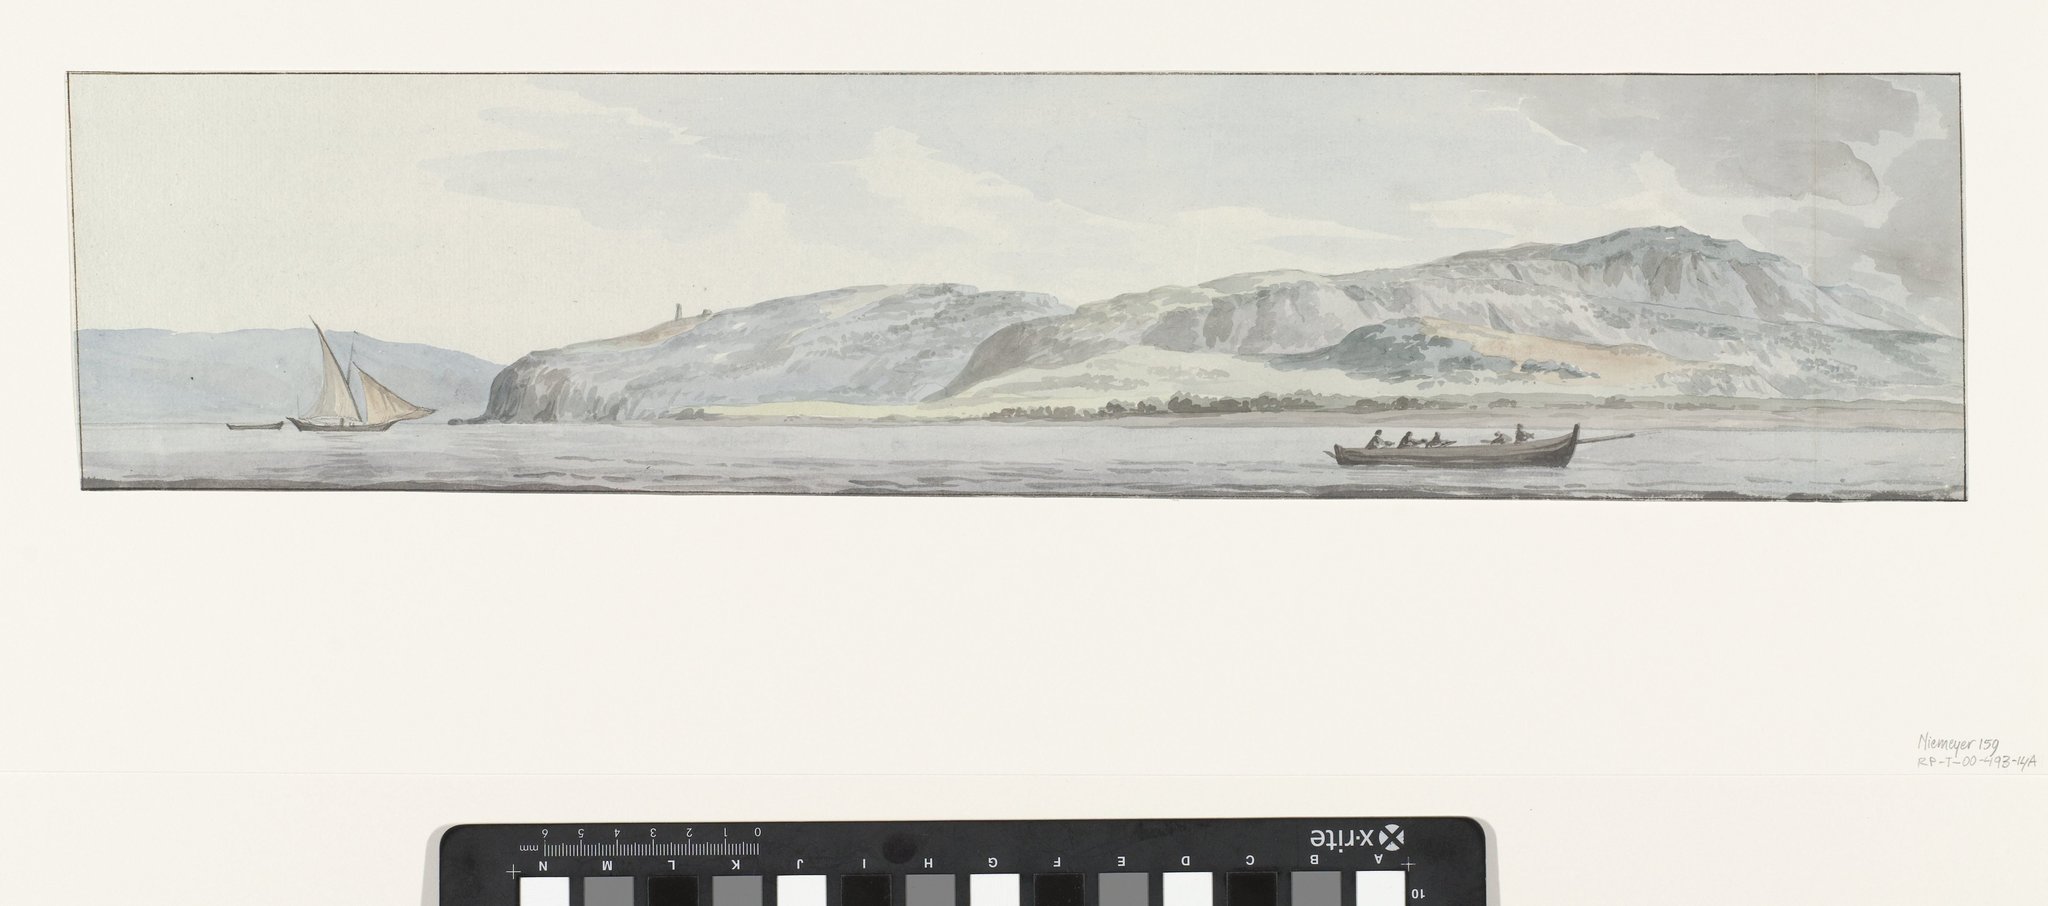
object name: watercolor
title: Vue du Capo dell'Armi avec l'entrée du Fare de Messine, & vue éloignée de la côte de Sicile vers Taormina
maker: louis ducros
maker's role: draughtsman, print maker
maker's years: 1748-1810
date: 1778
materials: chalk, paper, watercolor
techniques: brush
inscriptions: number: ‘No 126 Vue du Capo dell'Armi avec l'entrée du Fare de Messine, & vue éloignée de la côte de Sicile vers Taormina’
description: Tekening uit het album 'Voyage en Italie, en Sicile et à Malte', 1778.